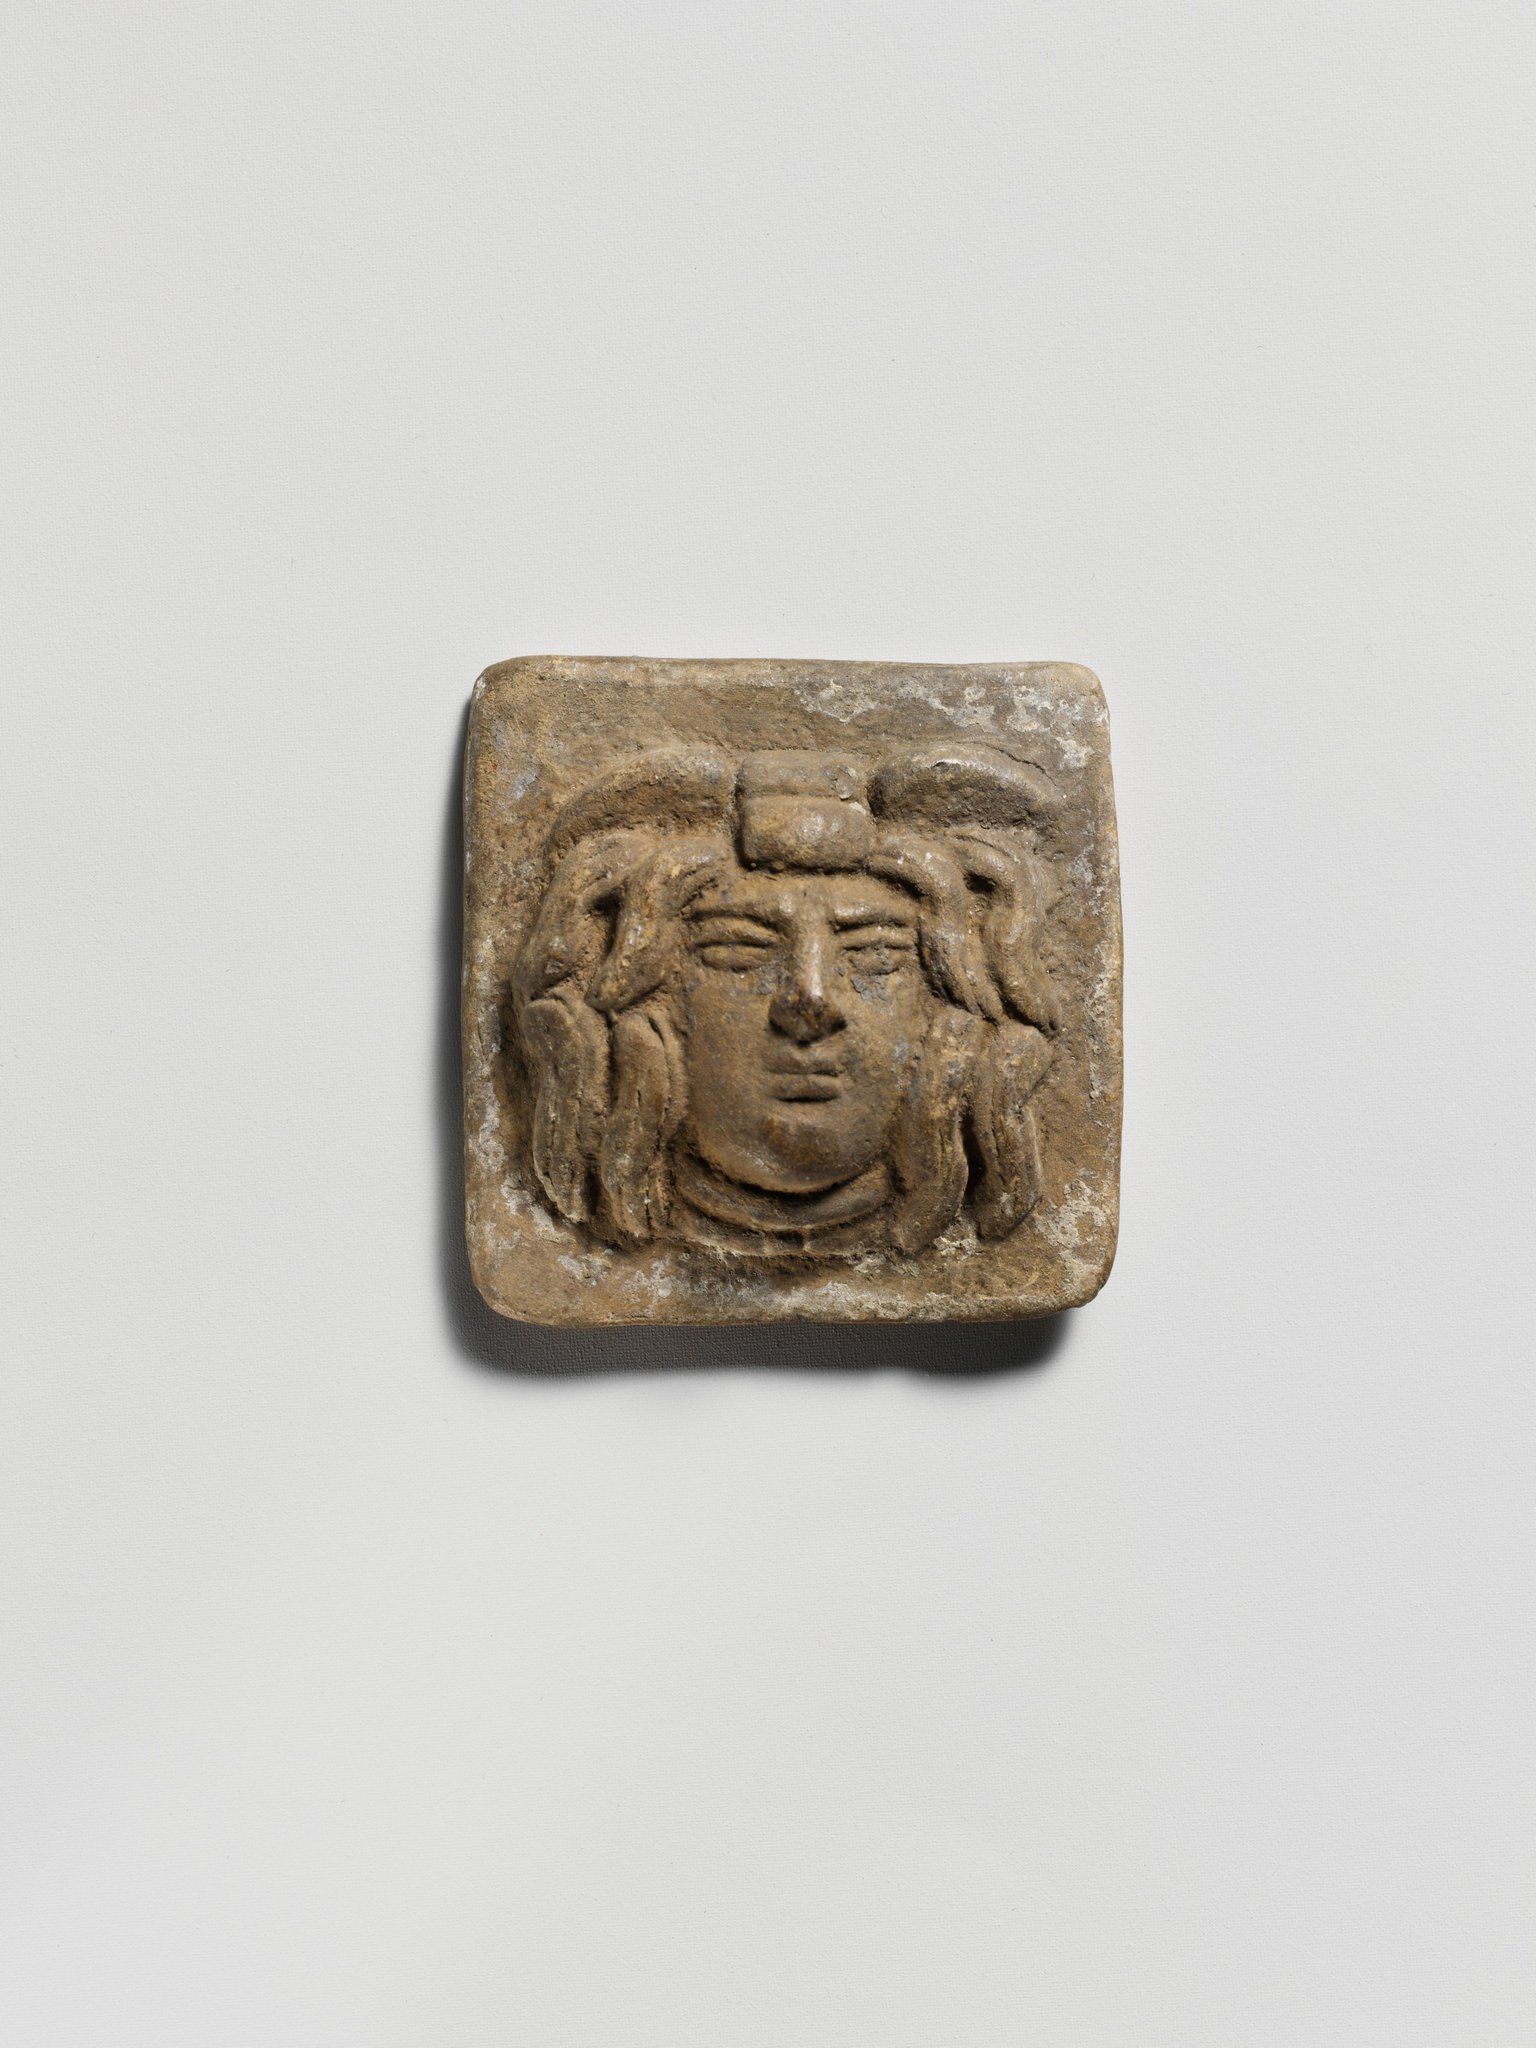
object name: head of medusa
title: Terracotta relief plaque with head of Medusa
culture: greek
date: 200-101 BCE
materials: terracotta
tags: medusa